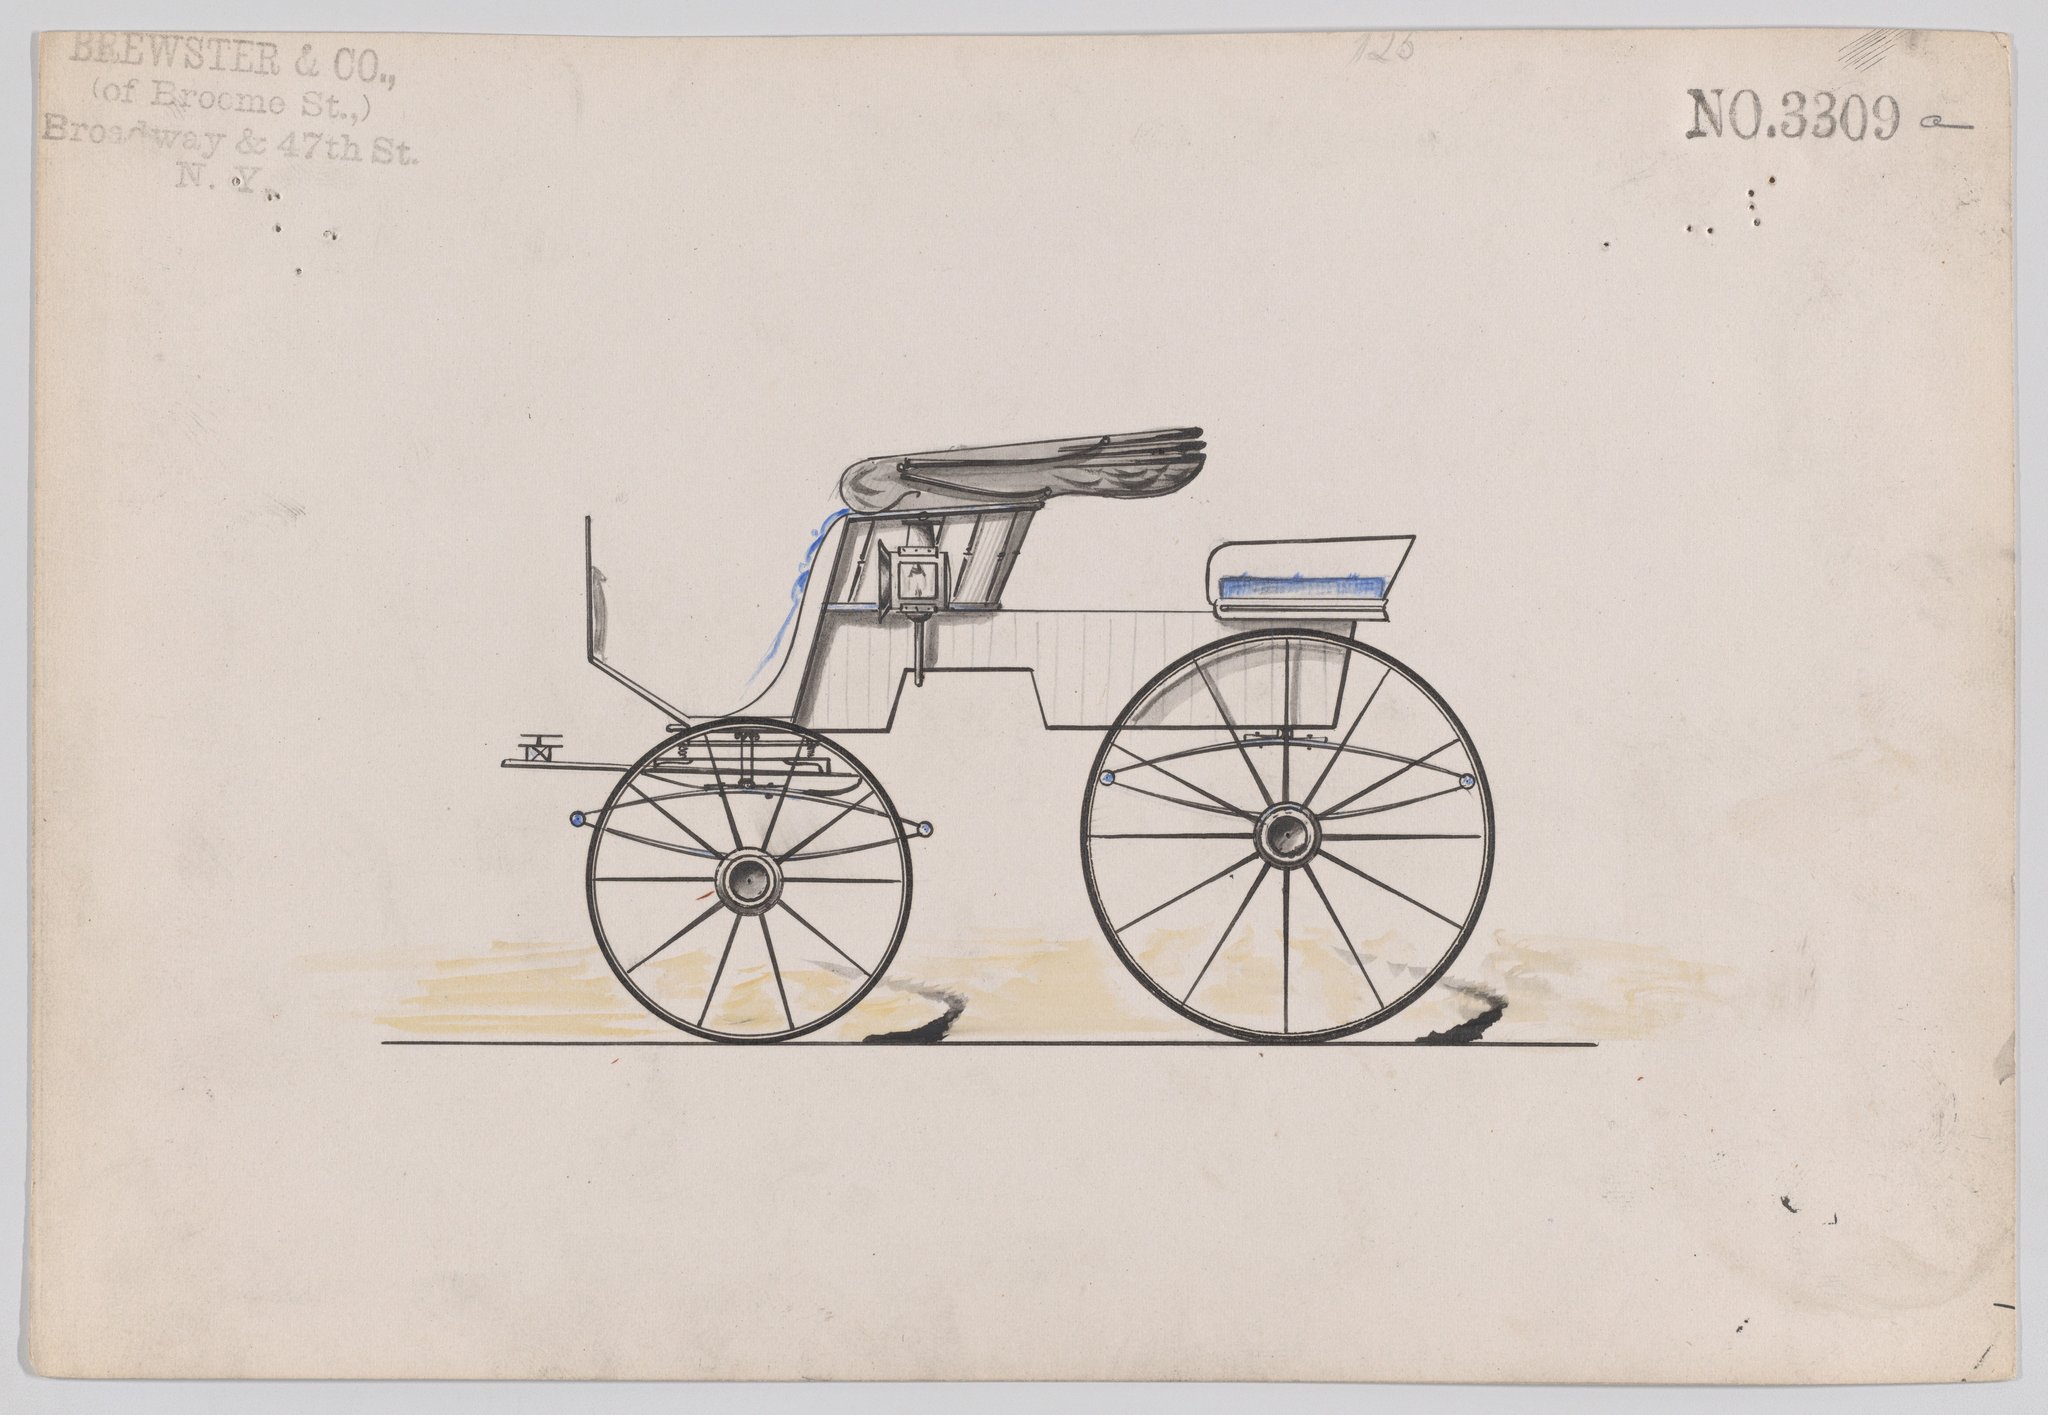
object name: drawing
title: Design for Stanhope Phaeton, no. 3309a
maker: brewster & co.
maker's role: manufacturer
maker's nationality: american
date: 1877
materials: gouache, graphite, ink, watercolor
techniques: pen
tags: carriages